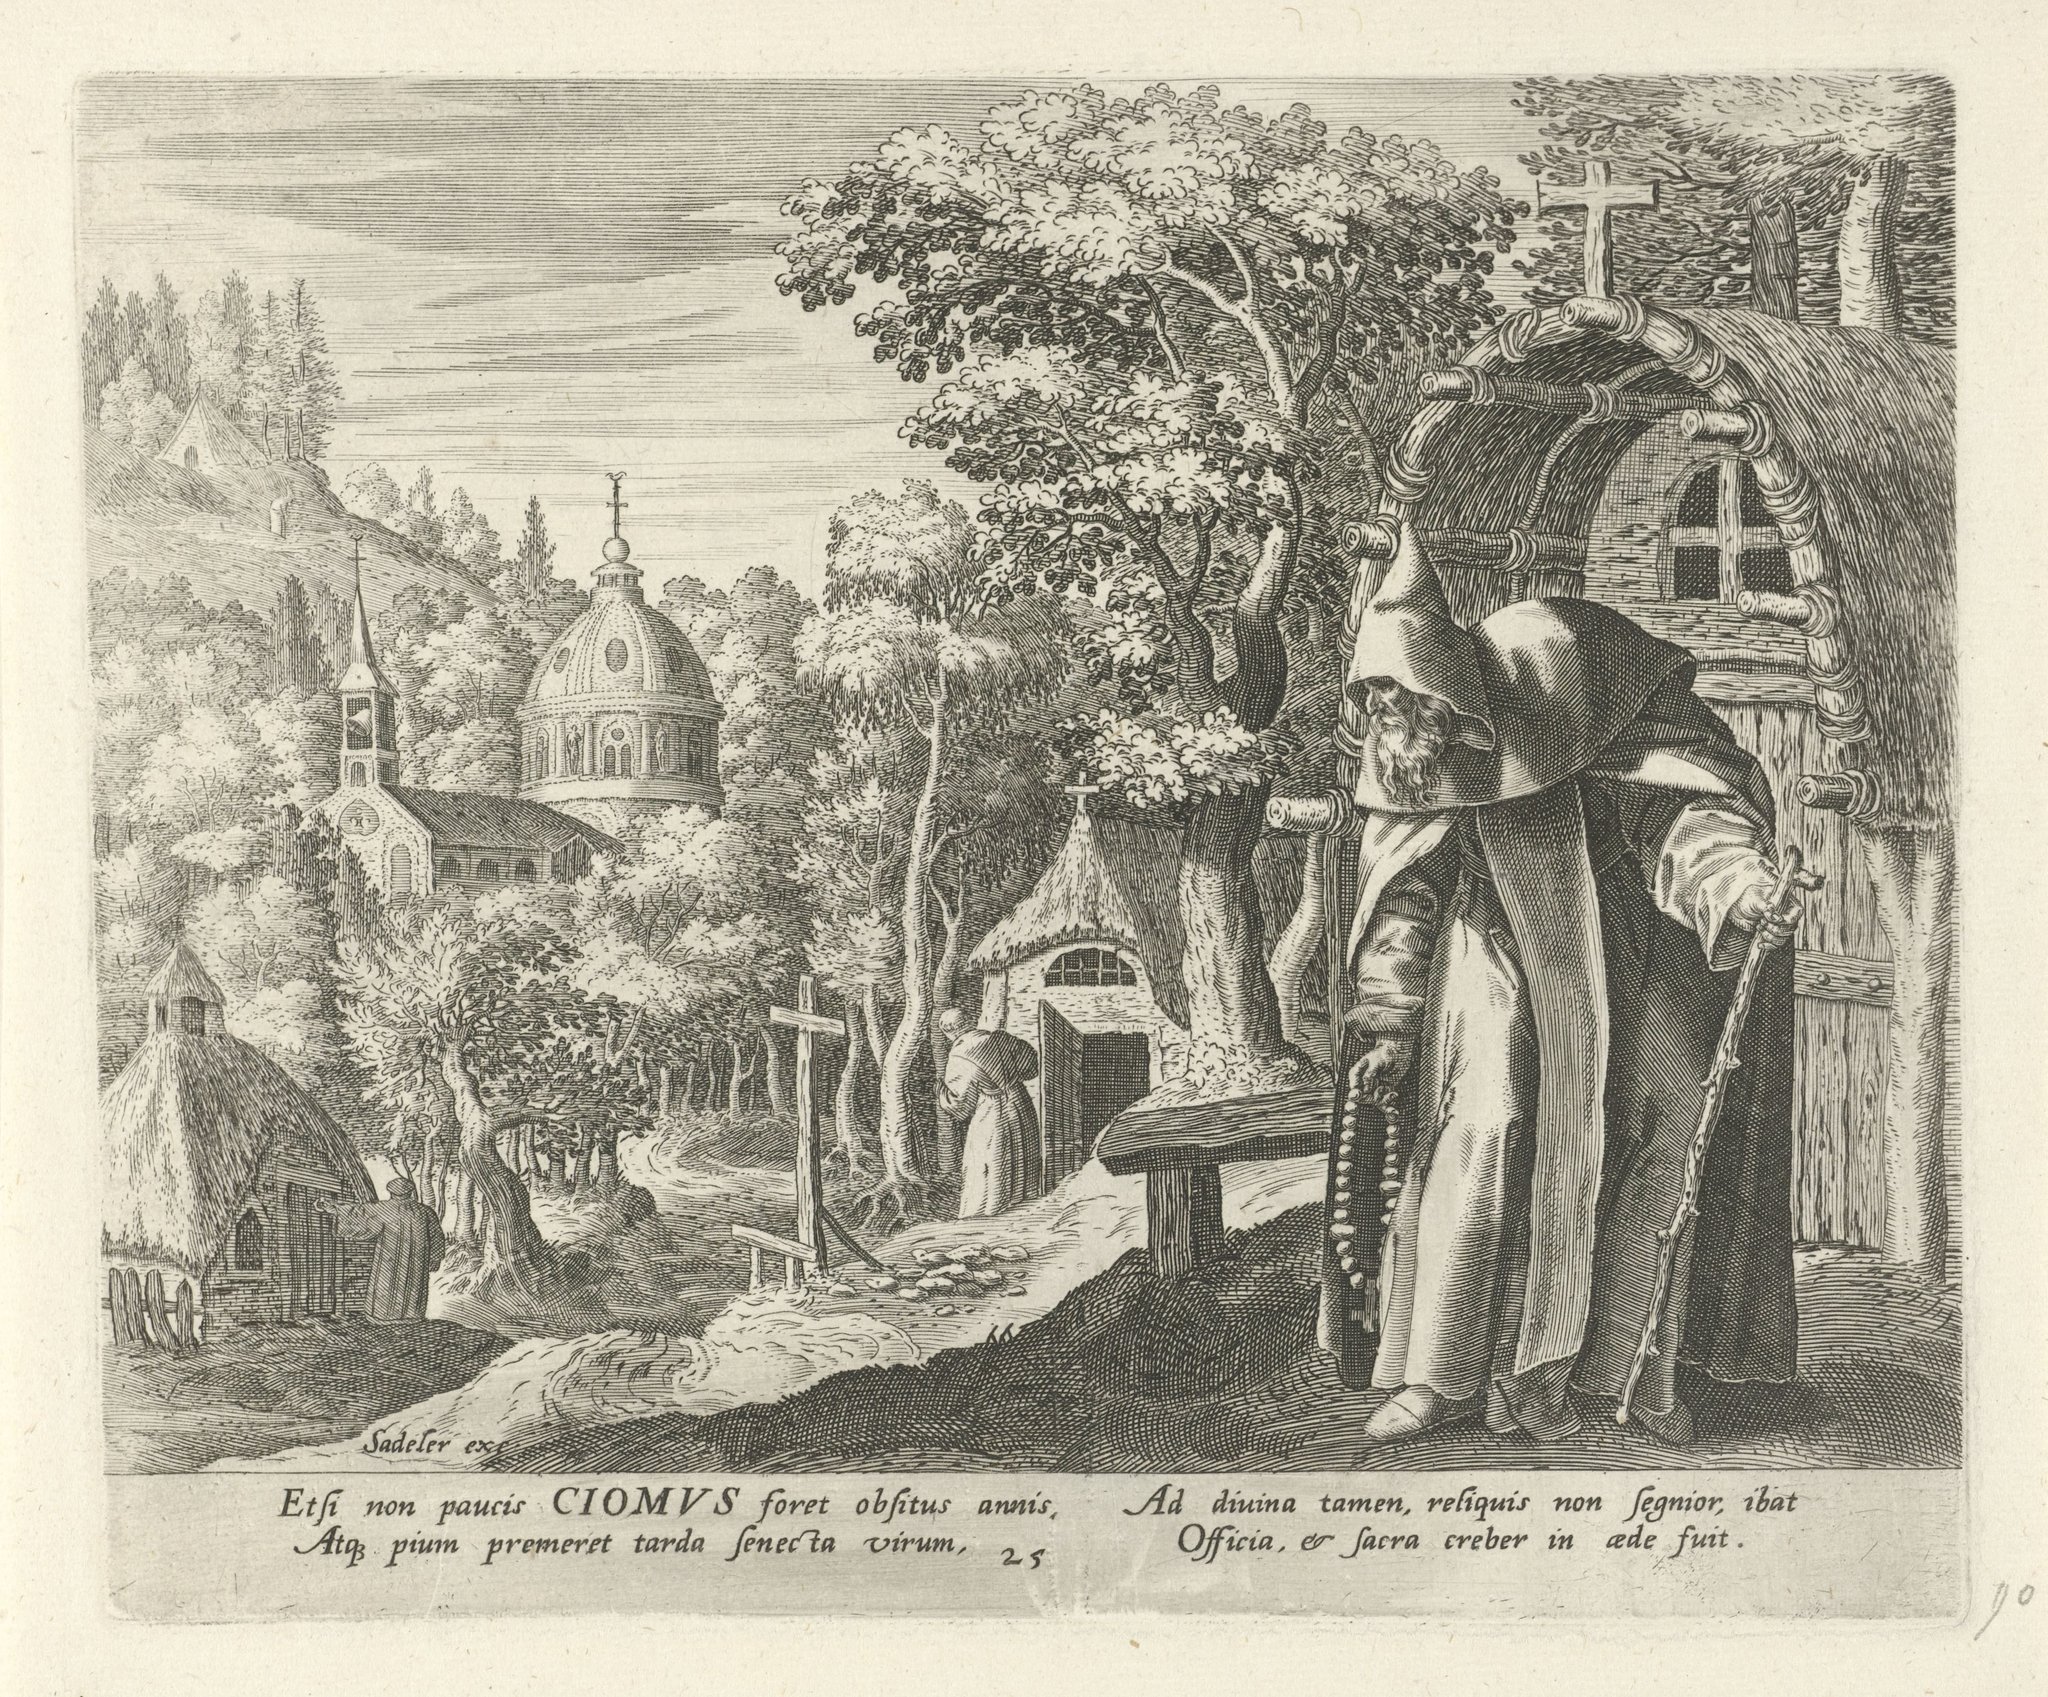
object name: print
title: Ciomus de kluizenaar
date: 1583-1588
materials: paper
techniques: engraving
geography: antwerp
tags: saints, village, anchorite, hermit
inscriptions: collector's mark: Lugt 2228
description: Ciomus de kluizenaar voor een hut. In zijn handen een staf en een rozenkrans. Op de achtergrond andere kluizenaars in een dorp.